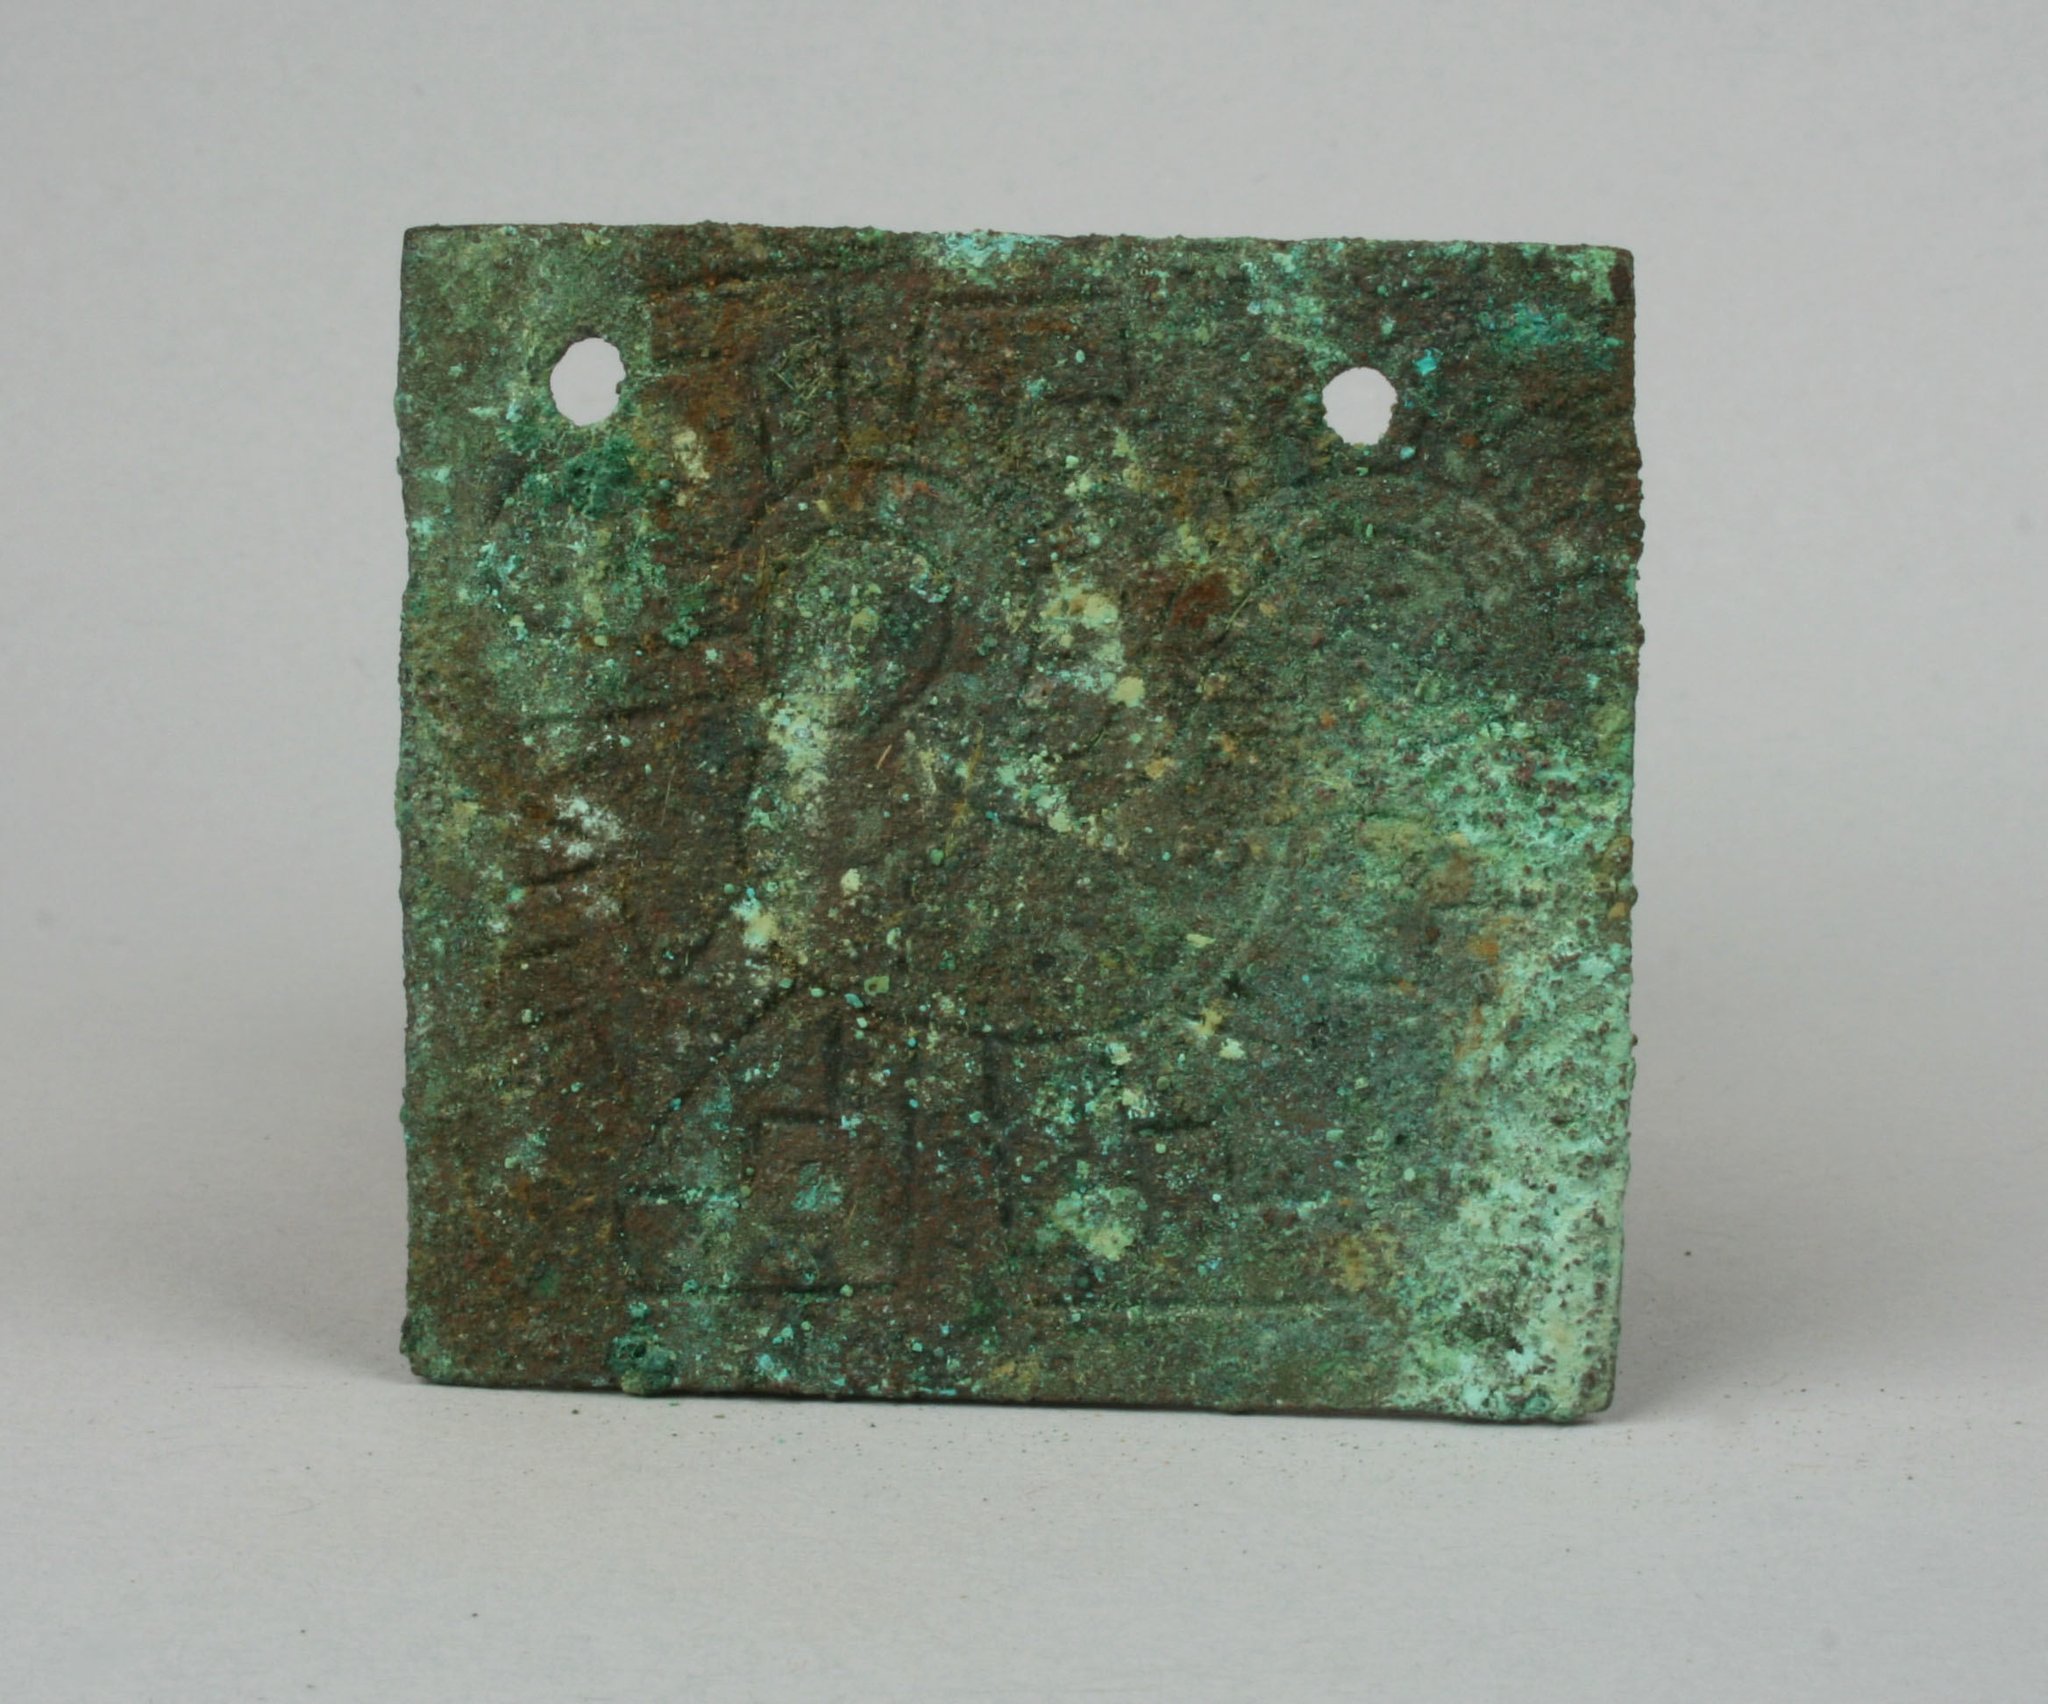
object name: ornament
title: Bird Plaque Ornament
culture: vicús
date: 300 BCE-200 CE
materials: copper, gilt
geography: peru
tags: birds